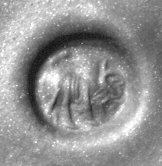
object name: stamp seal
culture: sasanian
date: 201-700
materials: bronze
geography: iran or mesopotamia